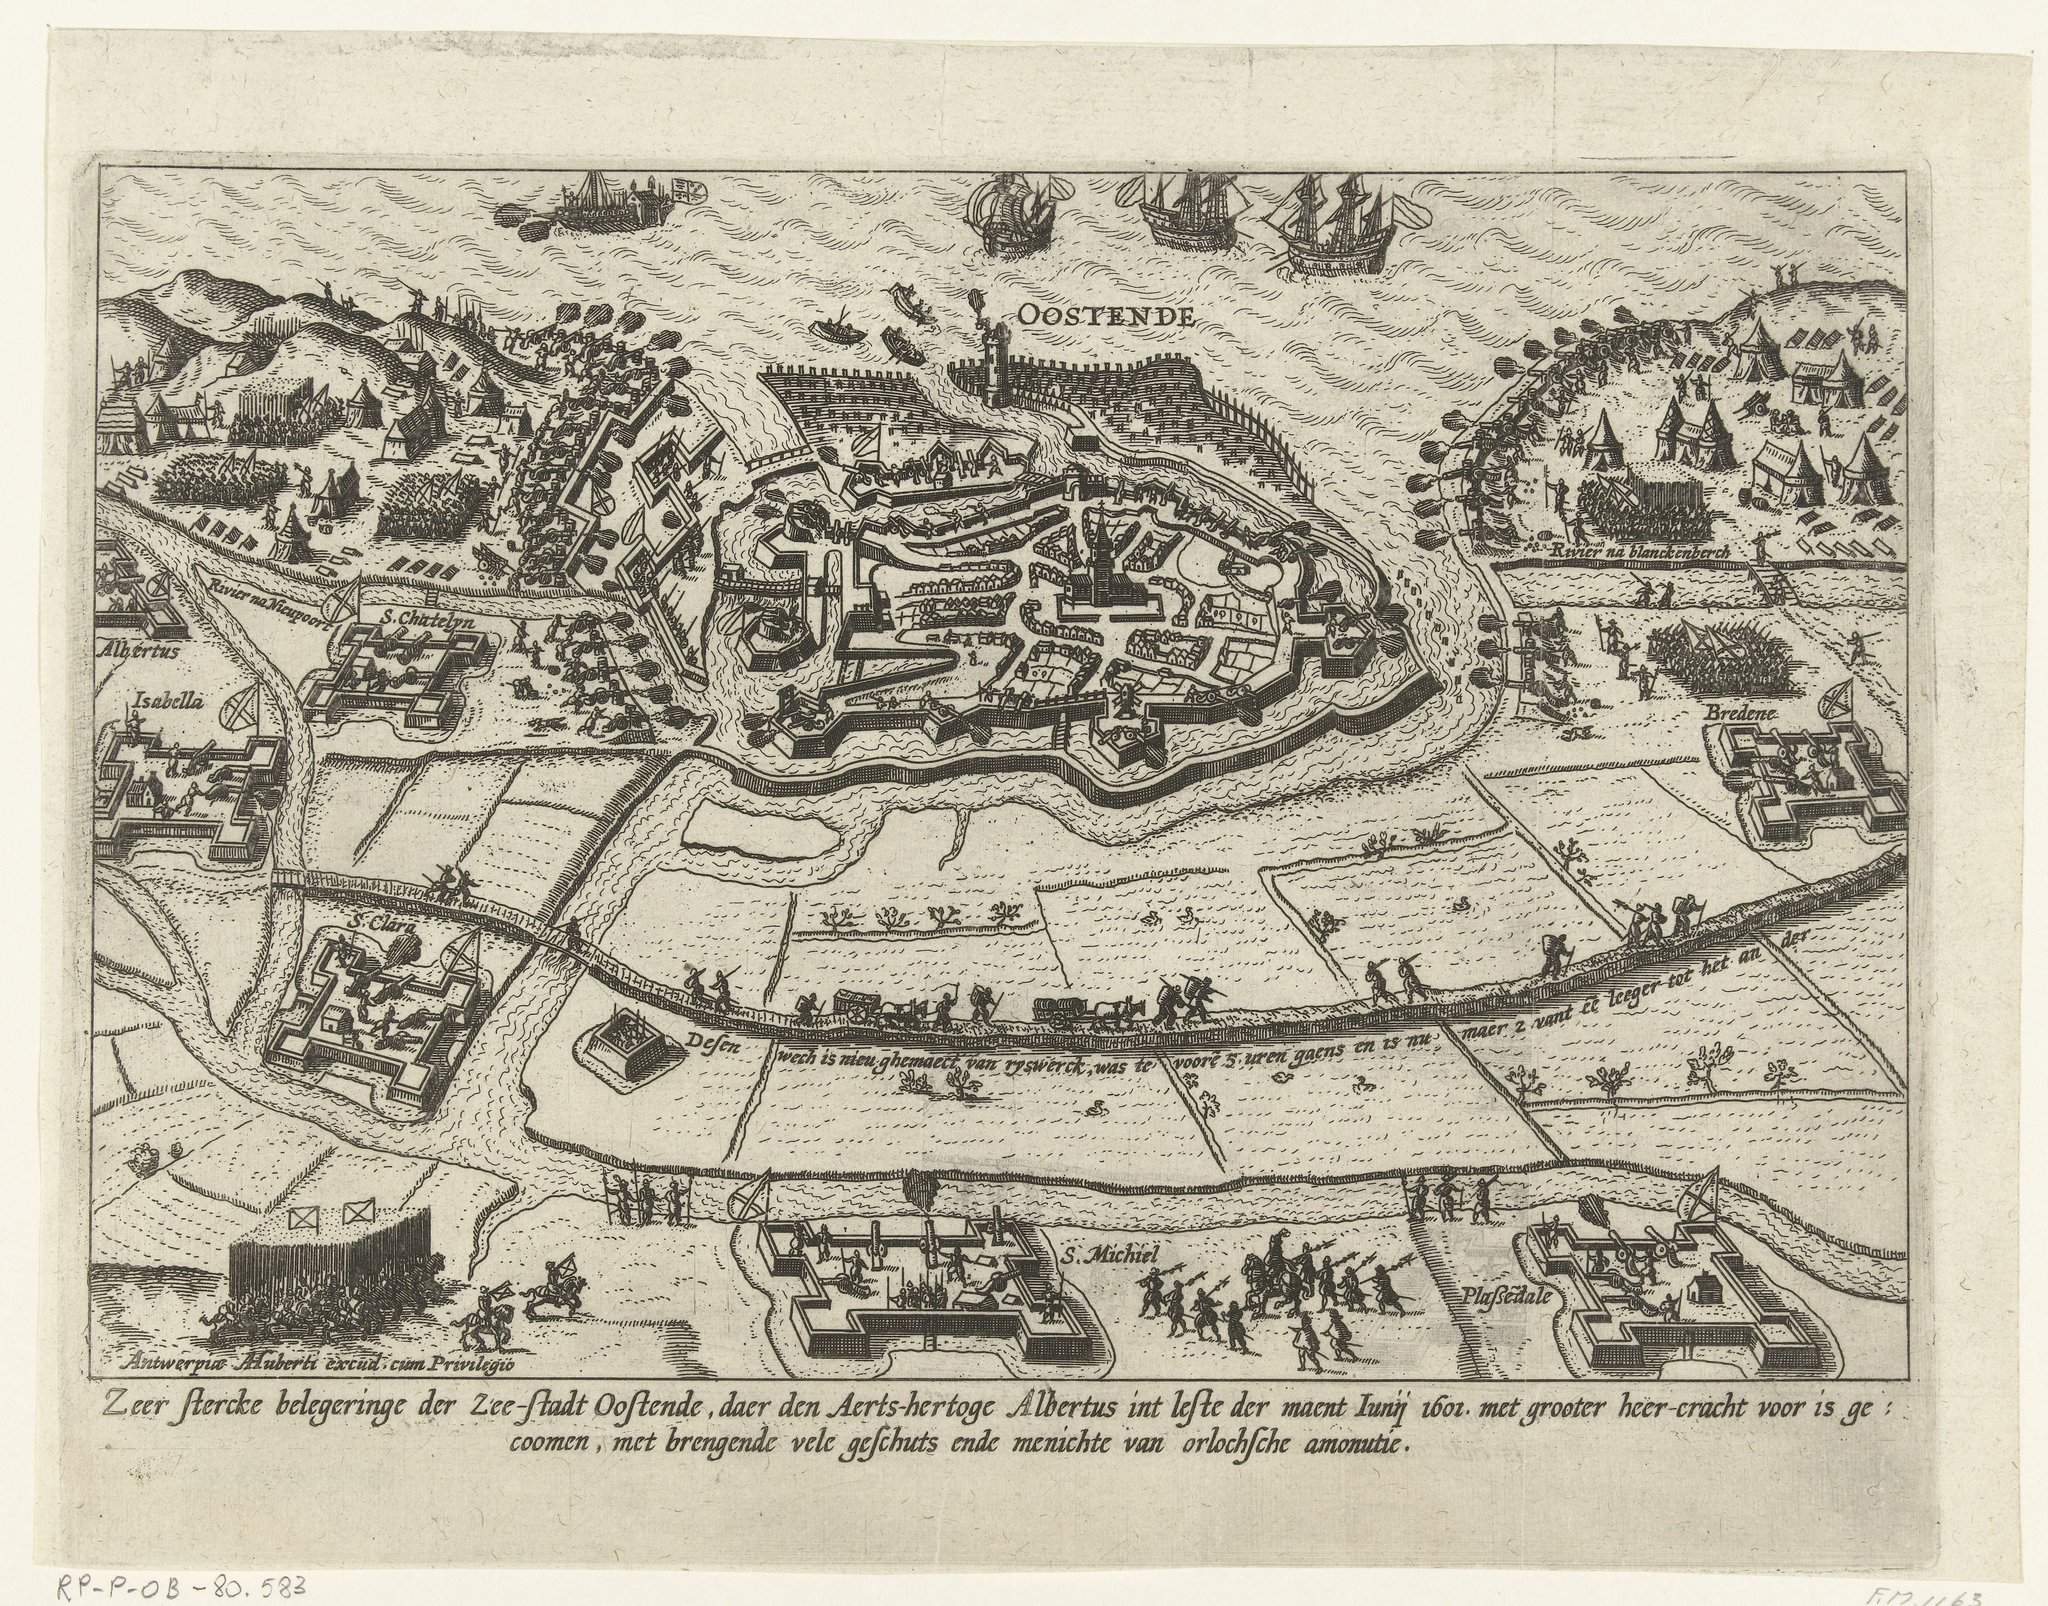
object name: print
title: Beleg van Oostende, 1601-1604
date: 1601-1603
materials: paper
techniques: etching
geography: southern netherlands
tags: siege, position war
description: Beleg van Oostende. Plan van de stad met het omliggende land met alle verdedigingswerken en de legerkampen van de belegeraars. Belegering van Oostende door het Spaanse leger onder Albertus en later onder Spinola van 1601-1604. Met onderschrift van 2 regels in het Nederlands.